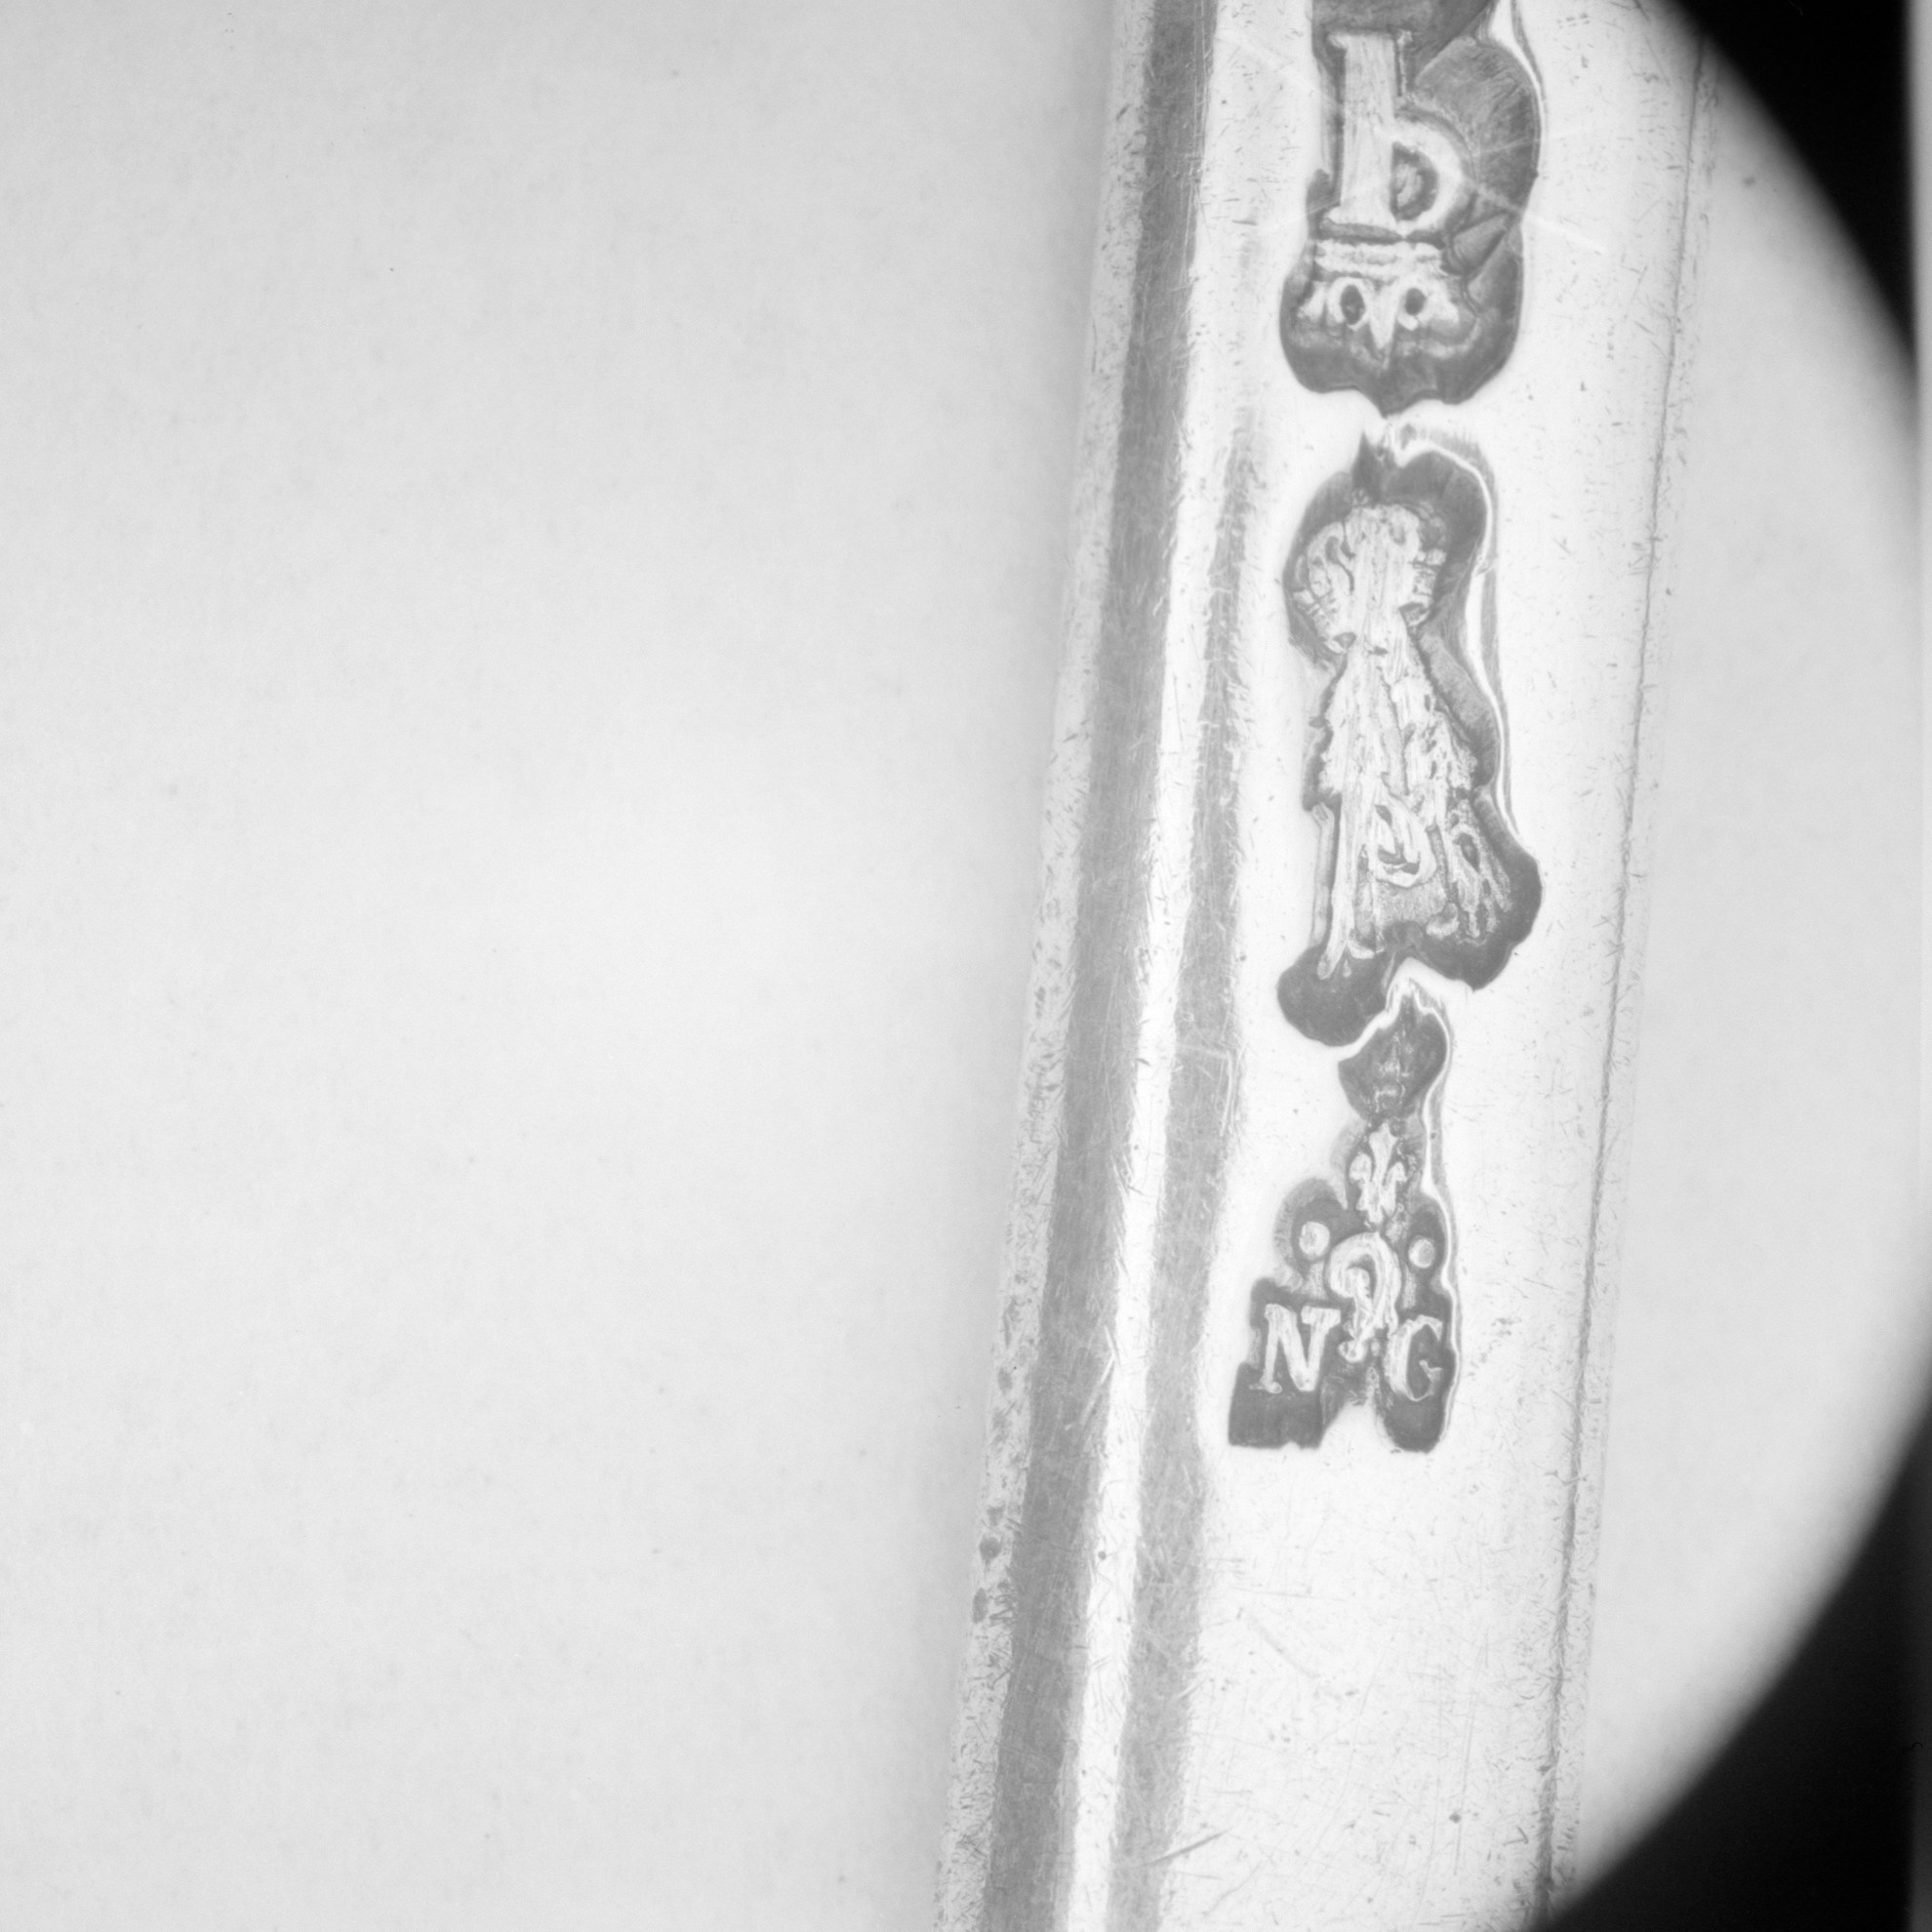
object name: spoon handle section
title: Section of a spoon handle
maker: nicolas gonthier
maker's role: maker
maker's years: 1738-1823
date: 1779-1780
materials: silver